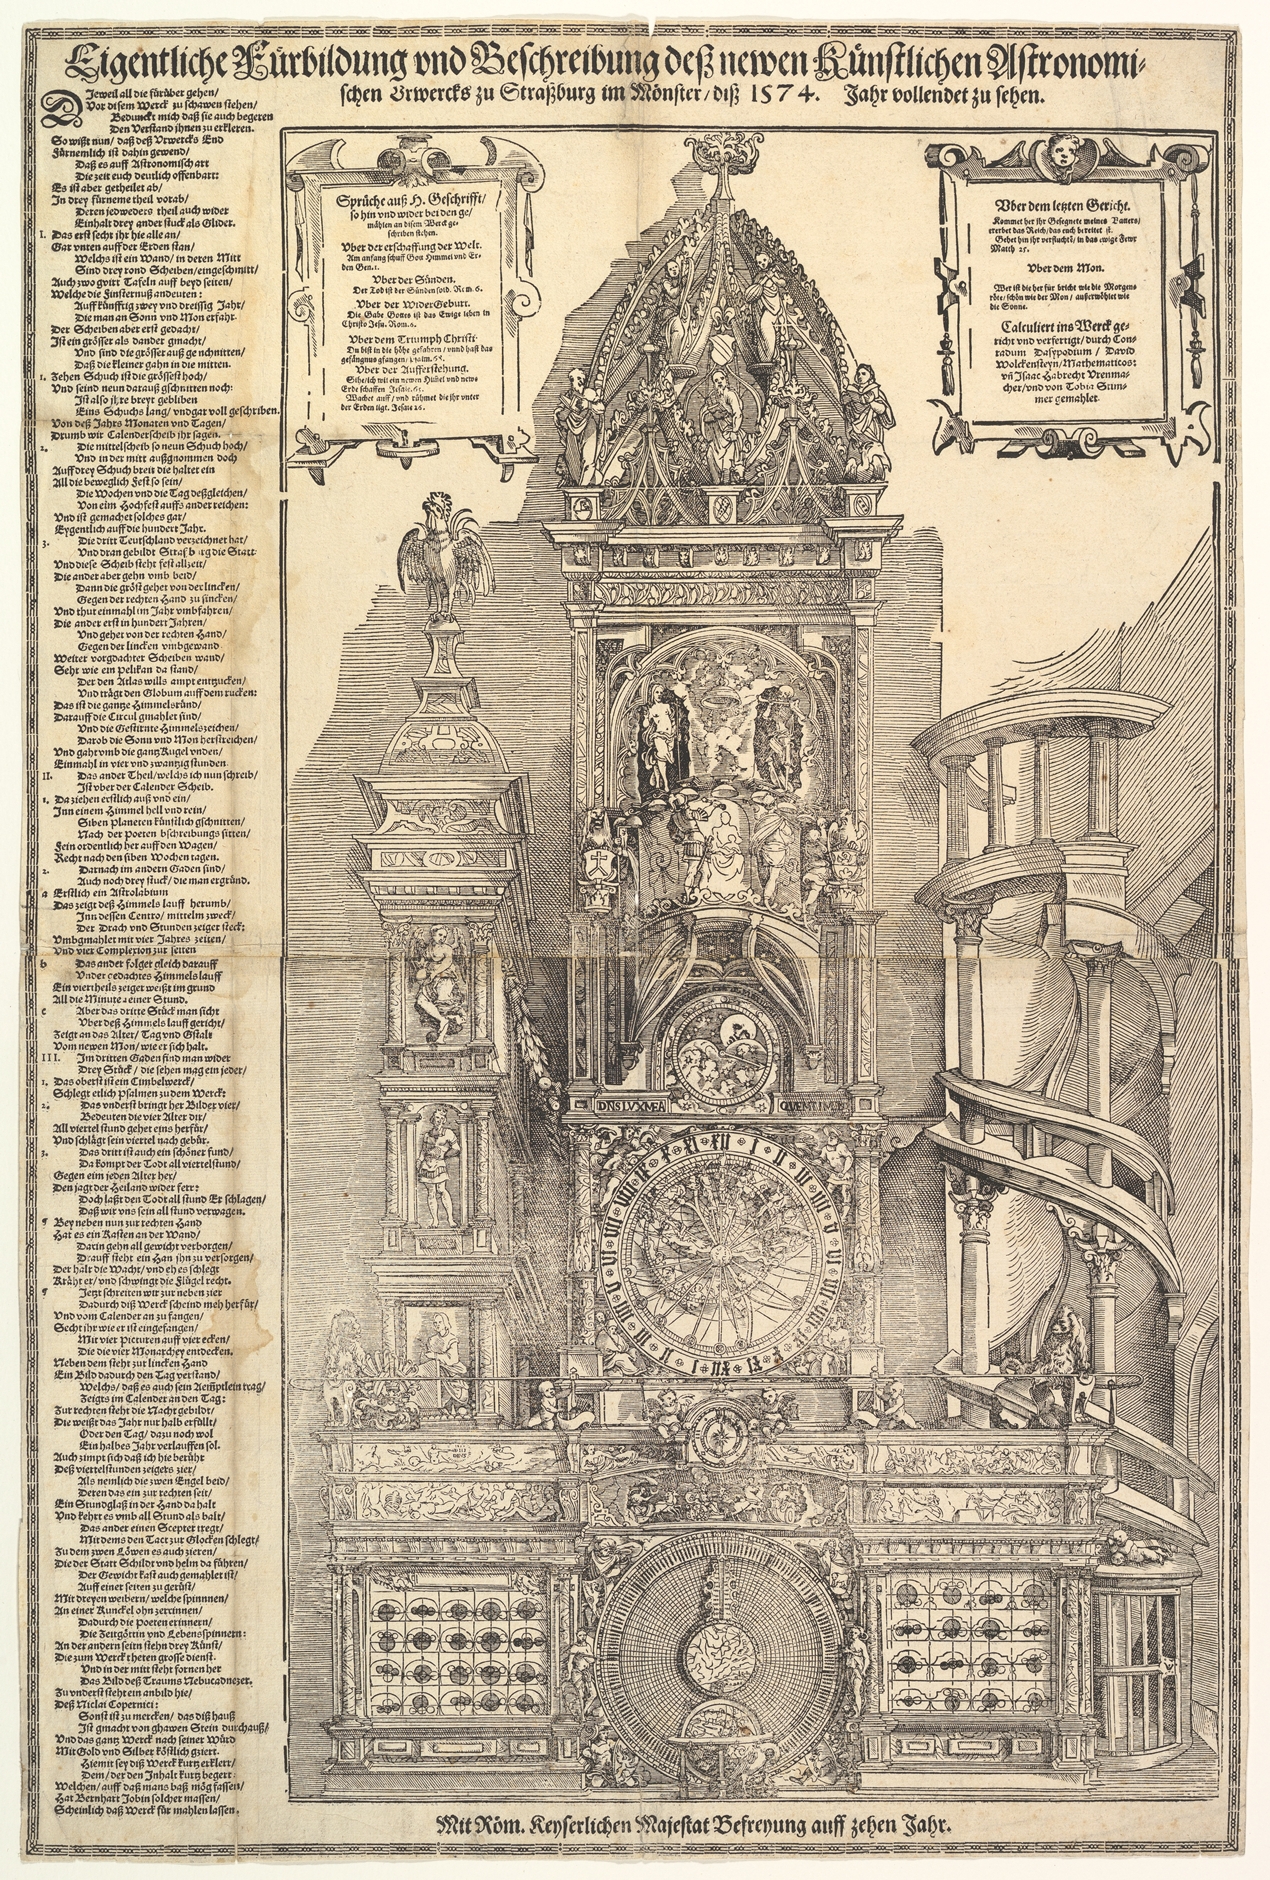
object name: collection ornament architecture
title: Astronomical Clock in the Cathedral in Strasbourg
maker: tobias stimmer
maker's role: artist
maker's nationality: swiss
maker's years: 1539-1584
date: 1574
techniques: letterpress, printing, woodcut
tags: birds,angels,clocks